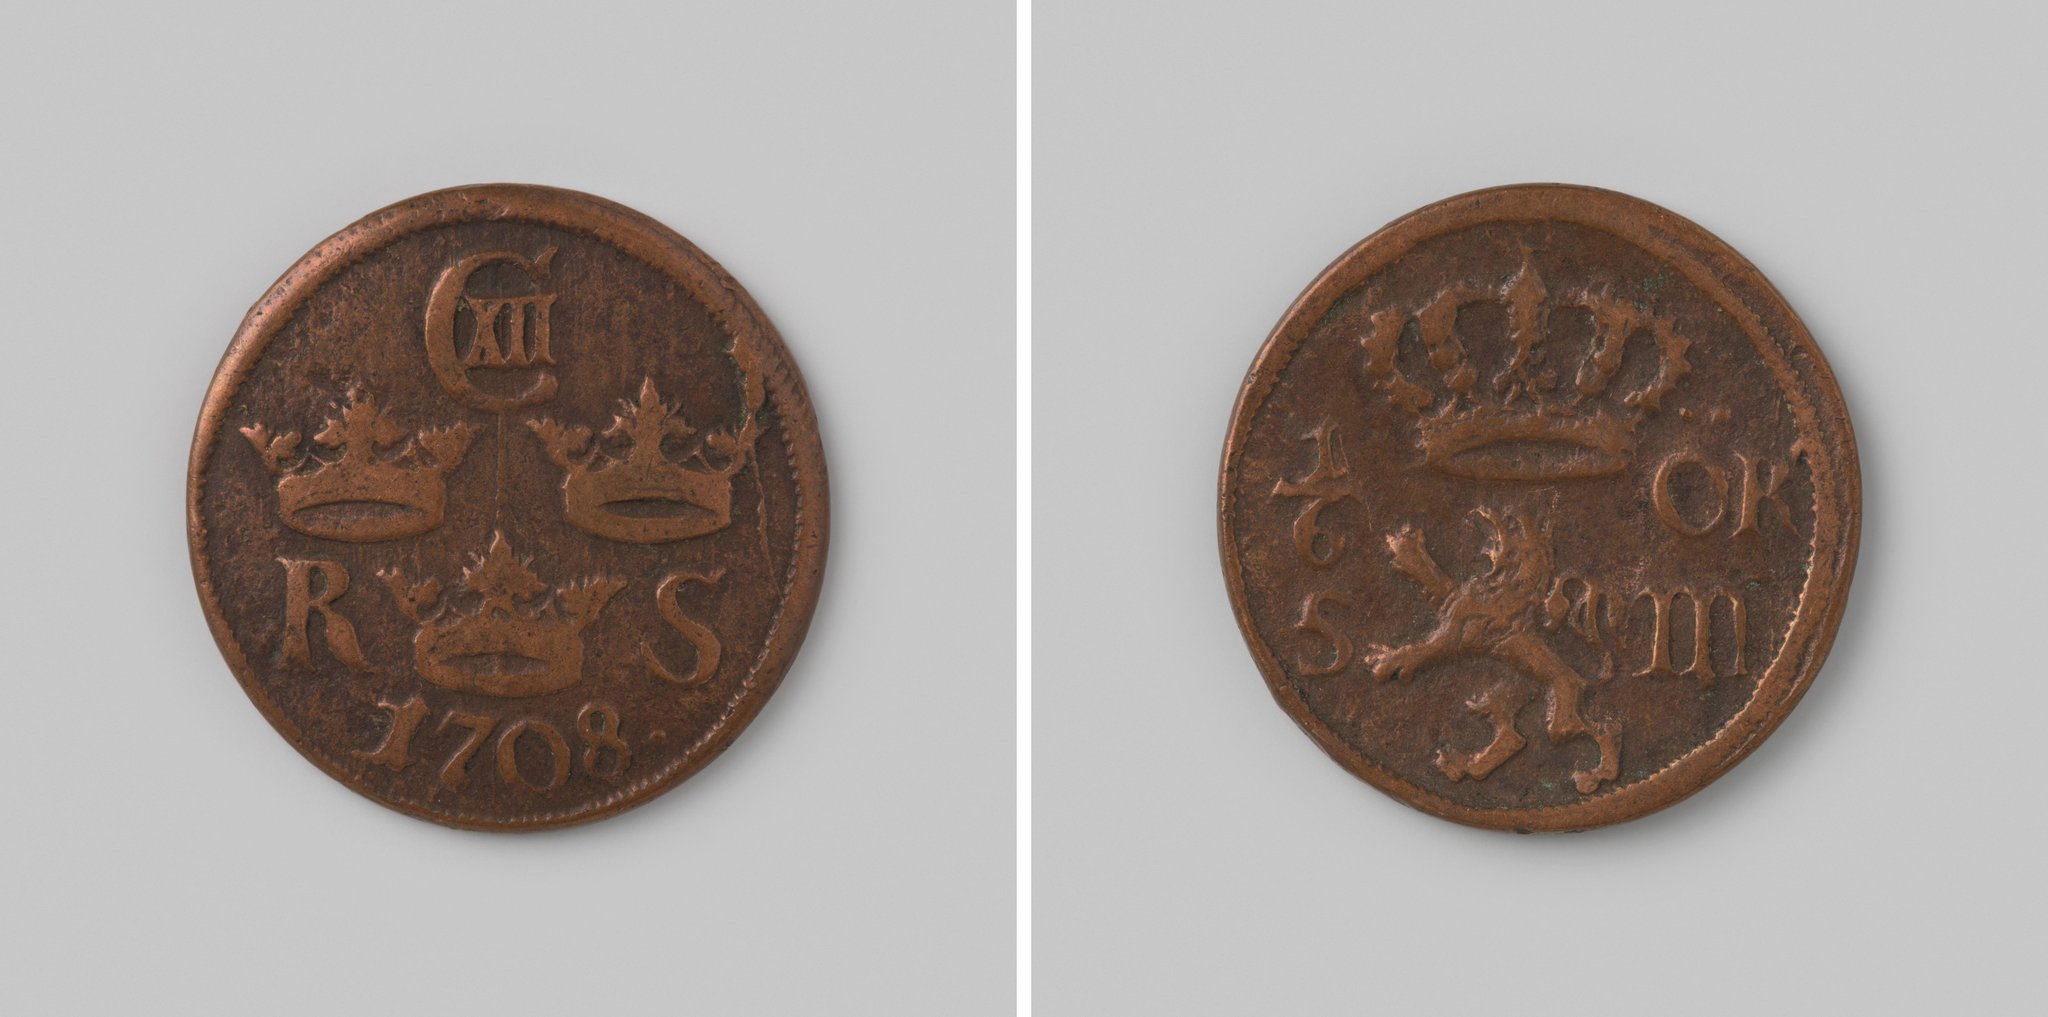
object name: coin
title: 1/6 öre Silver Mynt uit Zweden van Karel XII,1708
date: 1708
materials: copper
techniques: striking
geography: slot rörstrand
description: Koperen munt. Voorzijde: tussen drie kronen letters C-waarin XII-,S en R. Daaronder jaartal. Keerzijde: tussen waarde-aanduiding leeuw, waarboven kroon. Gladde rand.